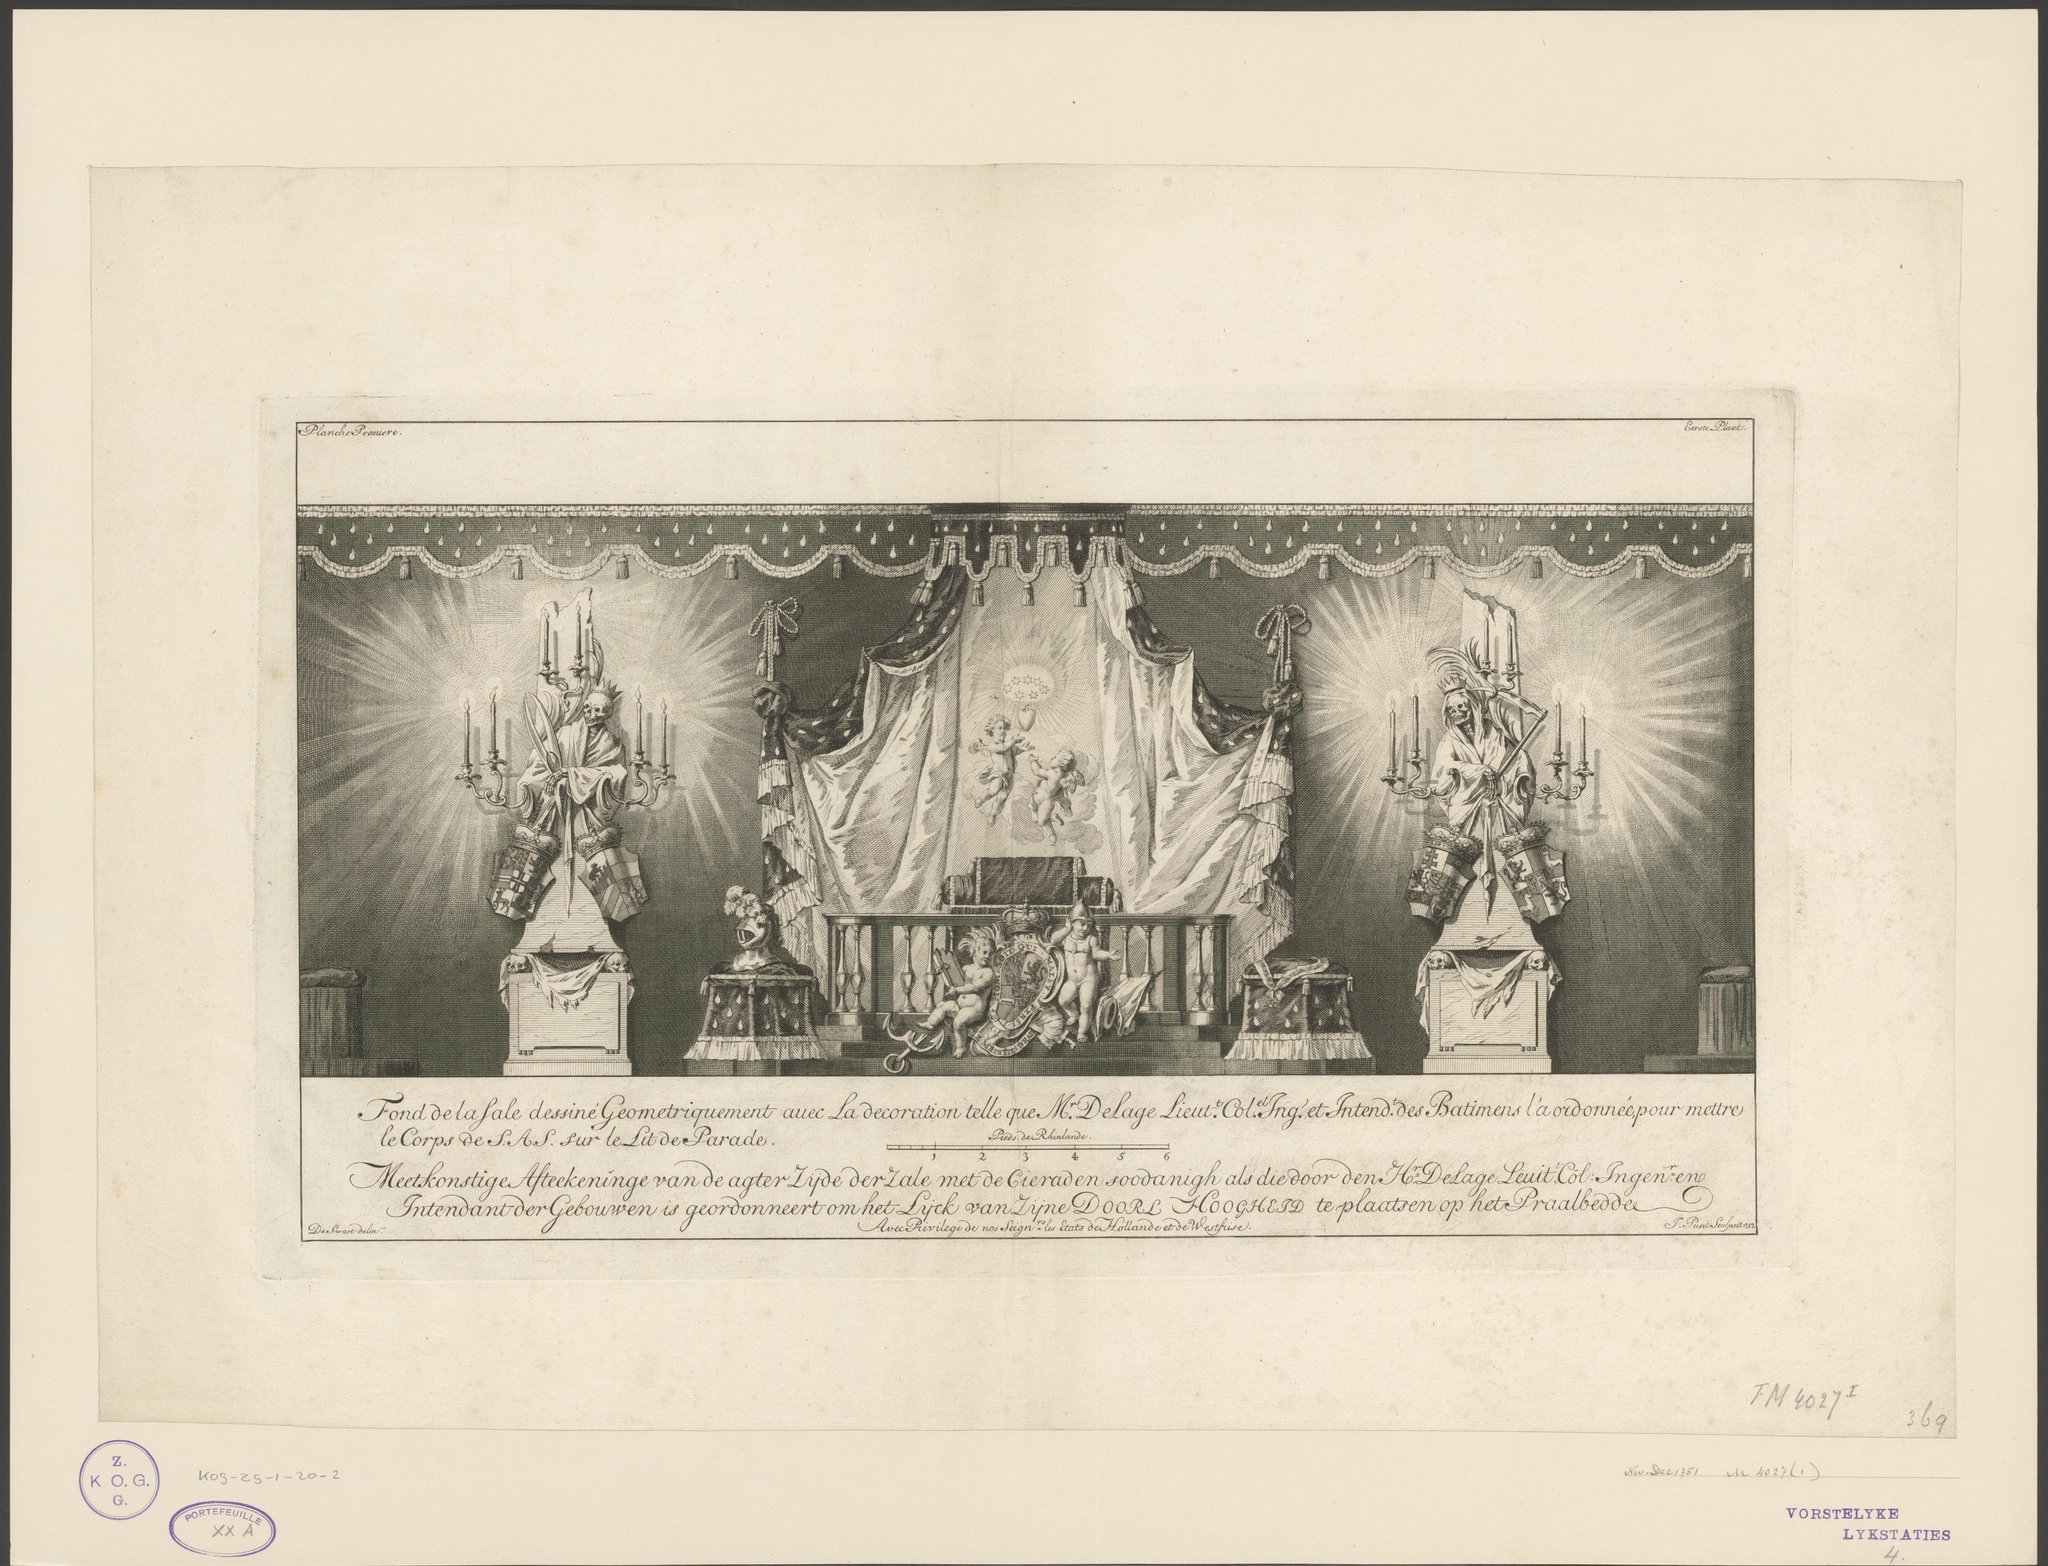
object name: print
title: Praalbed van Willem IV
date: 1752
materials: paper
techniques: engraving, etching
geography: the hague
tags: the hague, willem iv (prins van oranje-nassau), lying in state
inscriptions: stamp, stamp, collector's mark: Lugt 1641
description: Achterzijde van de zaal met het praalbed van prins Willem IV. Aan weerszijden van het bed kandelaren met wapens en skeletten. Onderdeel van de serie van vier platen van het praalbed waarop de op 22 oktober overleden prins Willem IV gedurende de maanden november en december van het jaar 1751 opgebaard heeft gelegen. Onderwerpsrubrieken binnen de Atlas Zeden en Gewoonten: Zeden en Gewoonten in Engeren Zin, Des menschen beging, midden en einde, Vorstelijke lijkstaties.